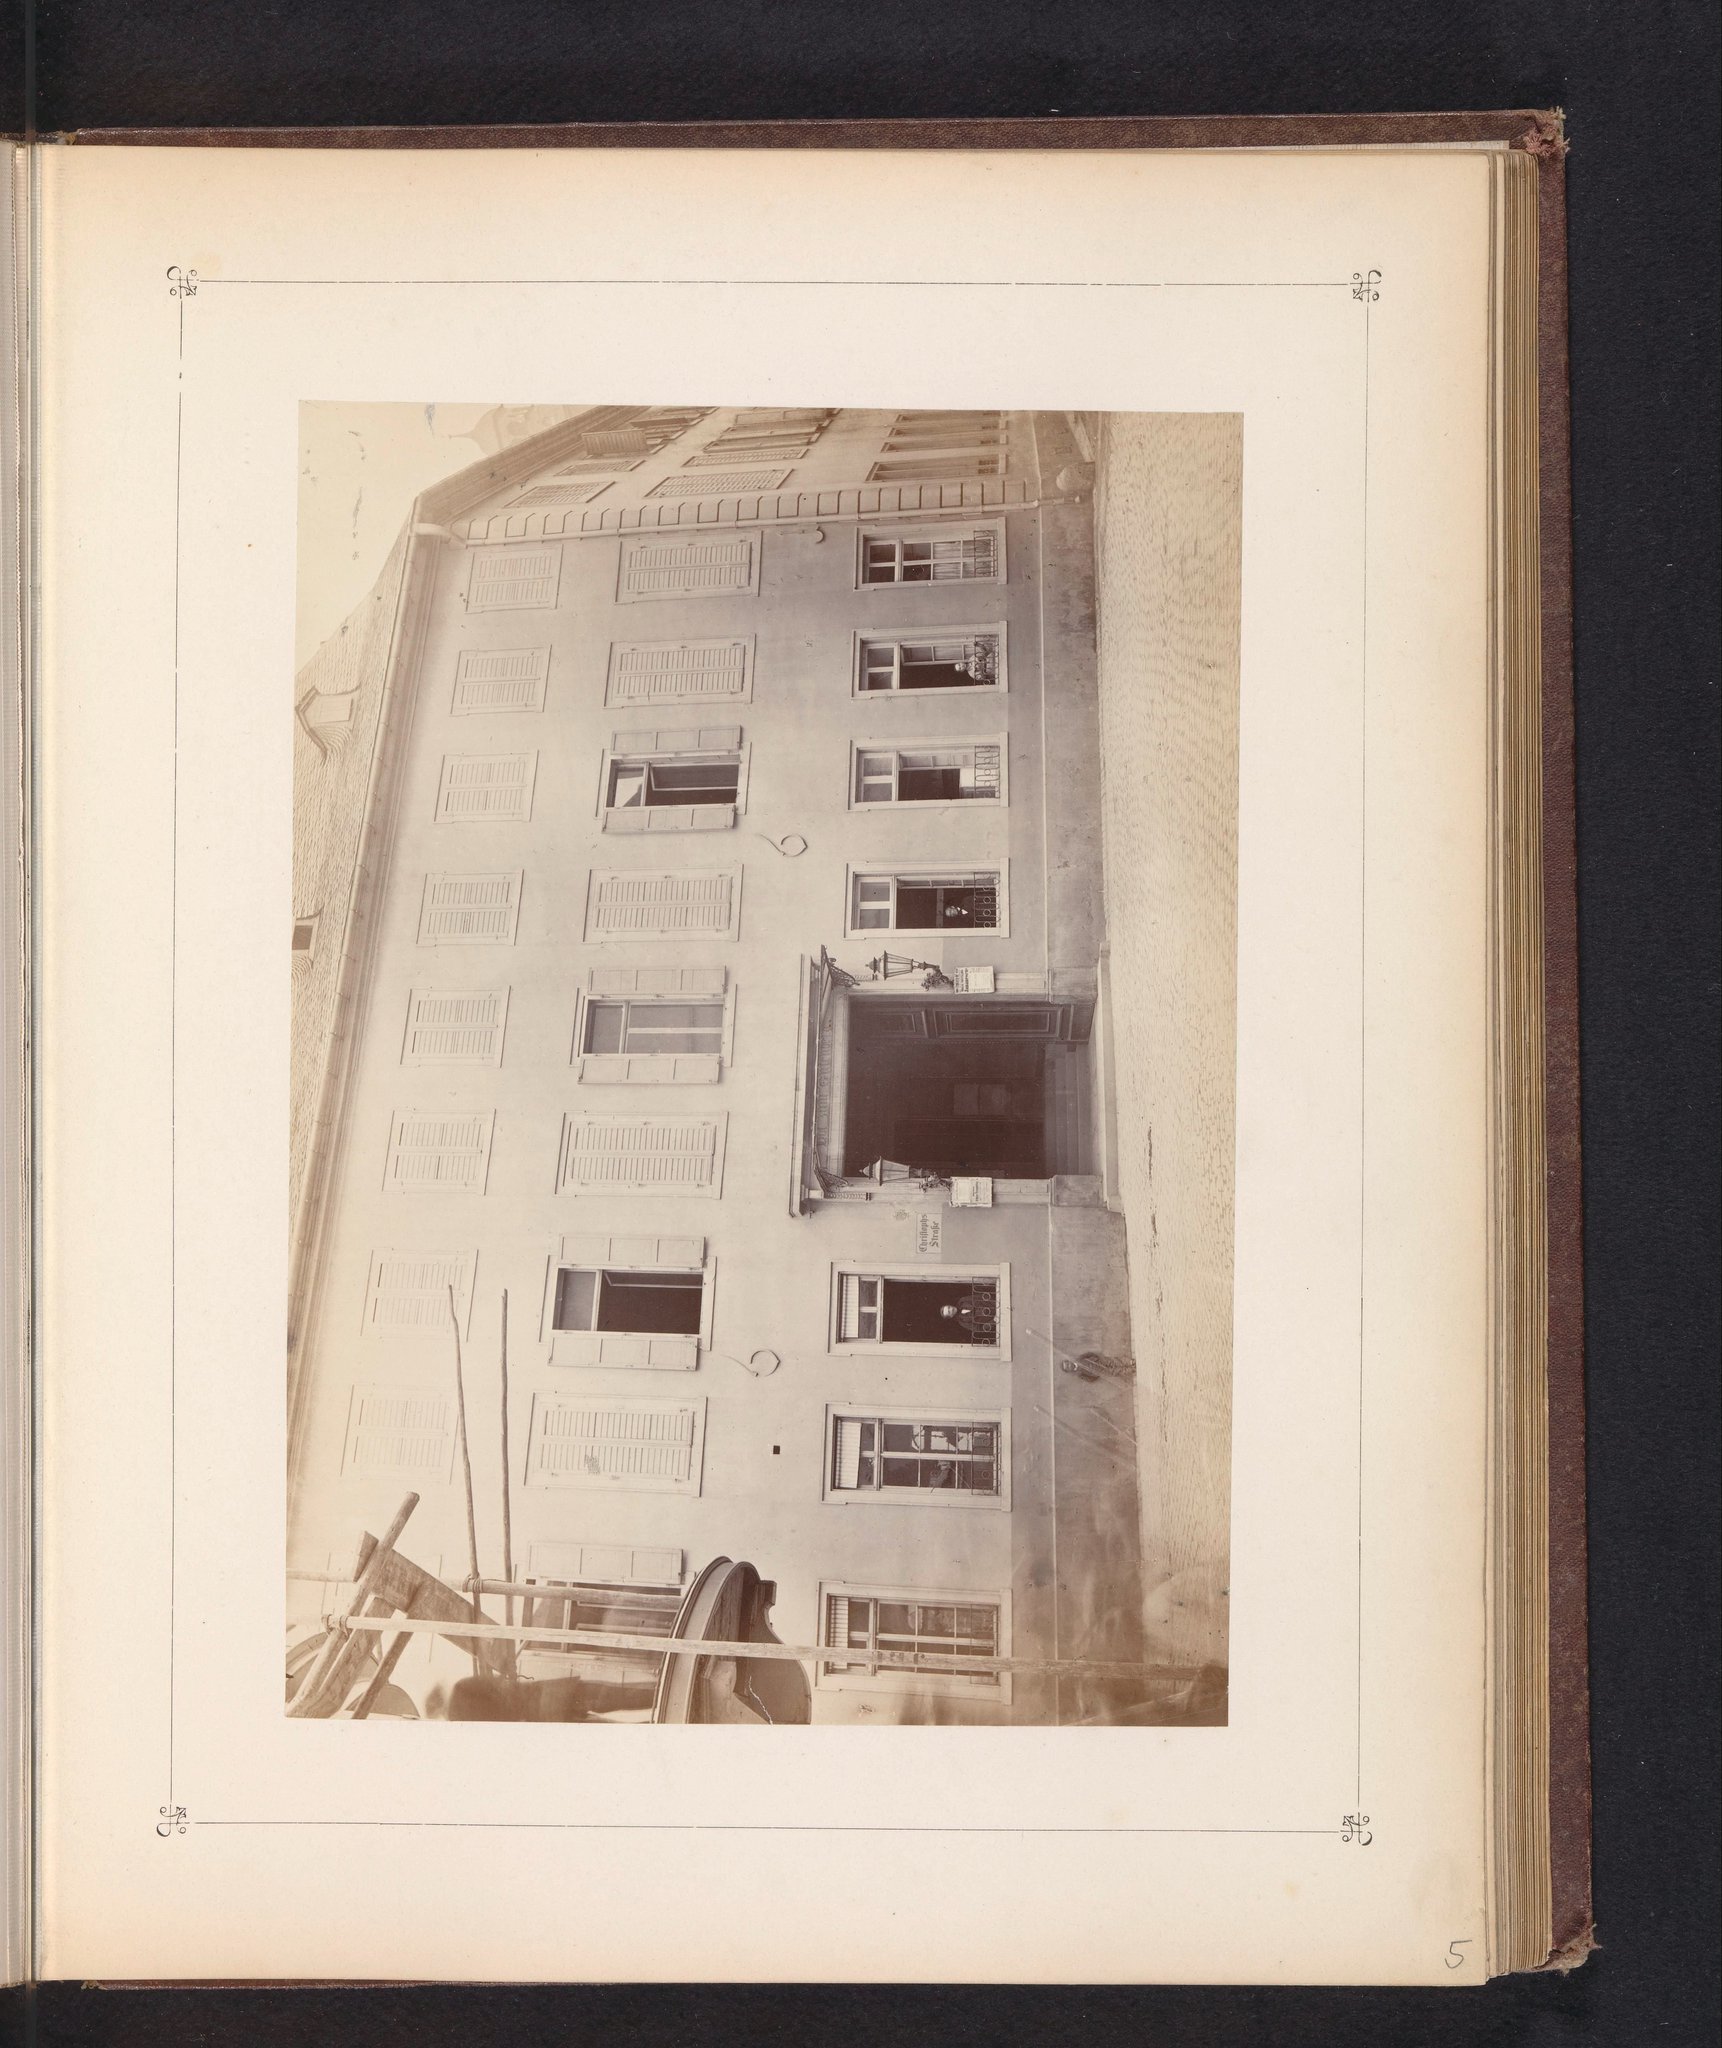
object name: page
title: Voorgevel van de woning van de familie Gensfleisch te Mainz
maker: b. erdmann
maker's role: fotograaf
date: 1867-1872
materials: photographic support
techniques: albumen print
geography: mainz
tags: housing, façade (of house or building)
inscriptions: number: ‘5’